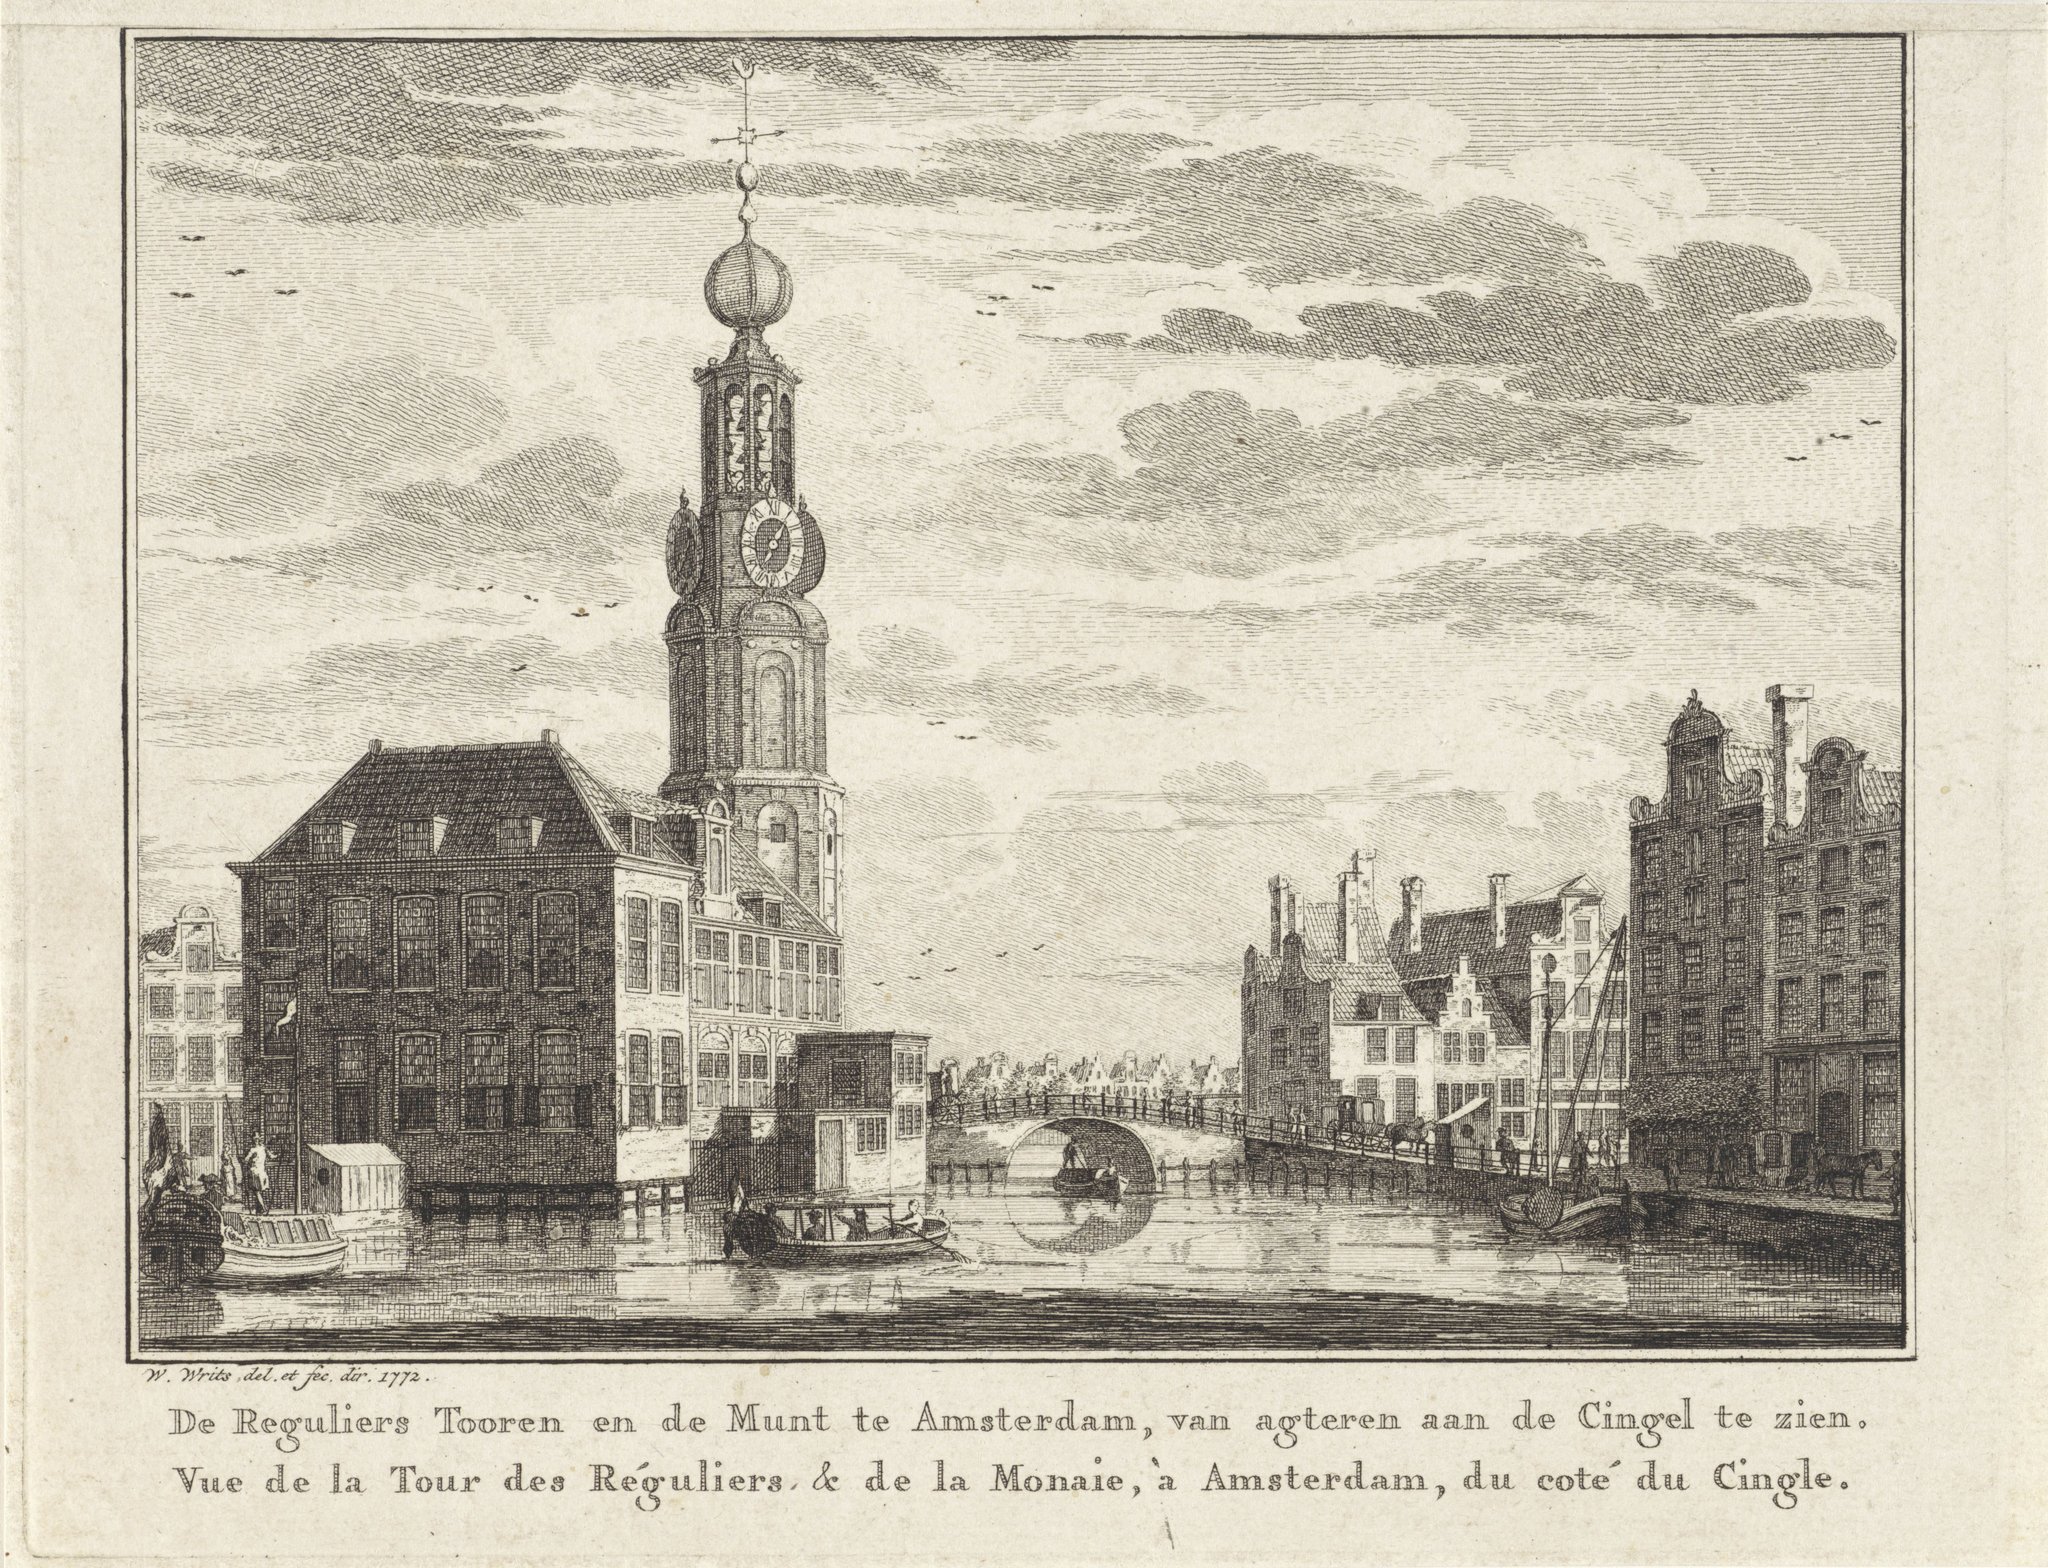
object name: print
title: Gezicht vanaf het Singel op de Munttoren te Amsterdam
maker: willem writs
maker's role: draughtsman, print maker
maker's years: 1731-1786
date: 1772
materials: paper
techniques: etching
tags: munttoren, singel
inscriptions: collector's mark: Lugt 2228